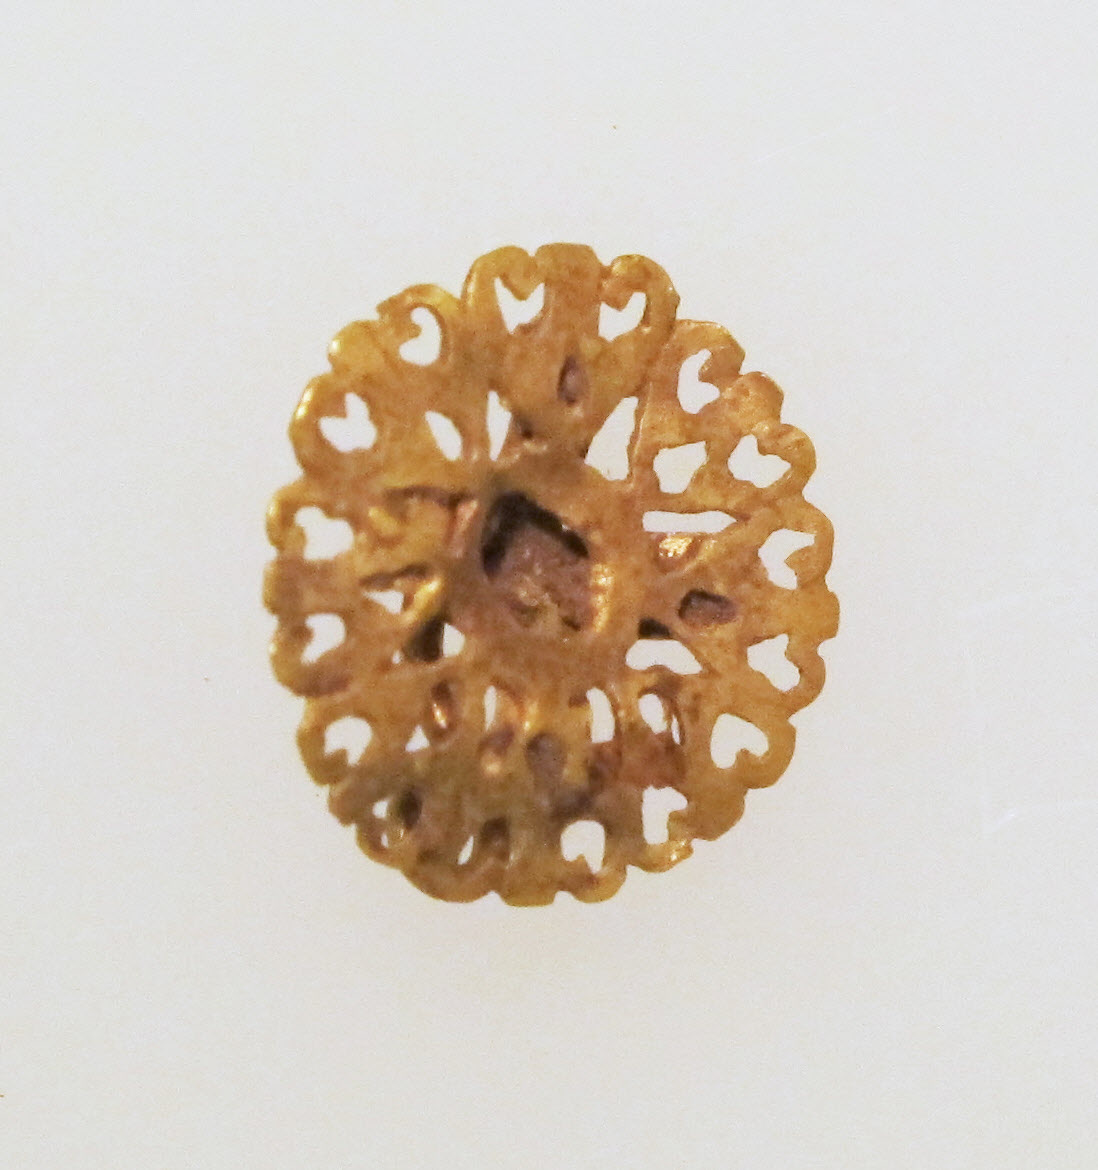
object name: earring hook type with disc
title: Earring-hook type with disc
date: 7000 BCE-330 CE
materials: gold